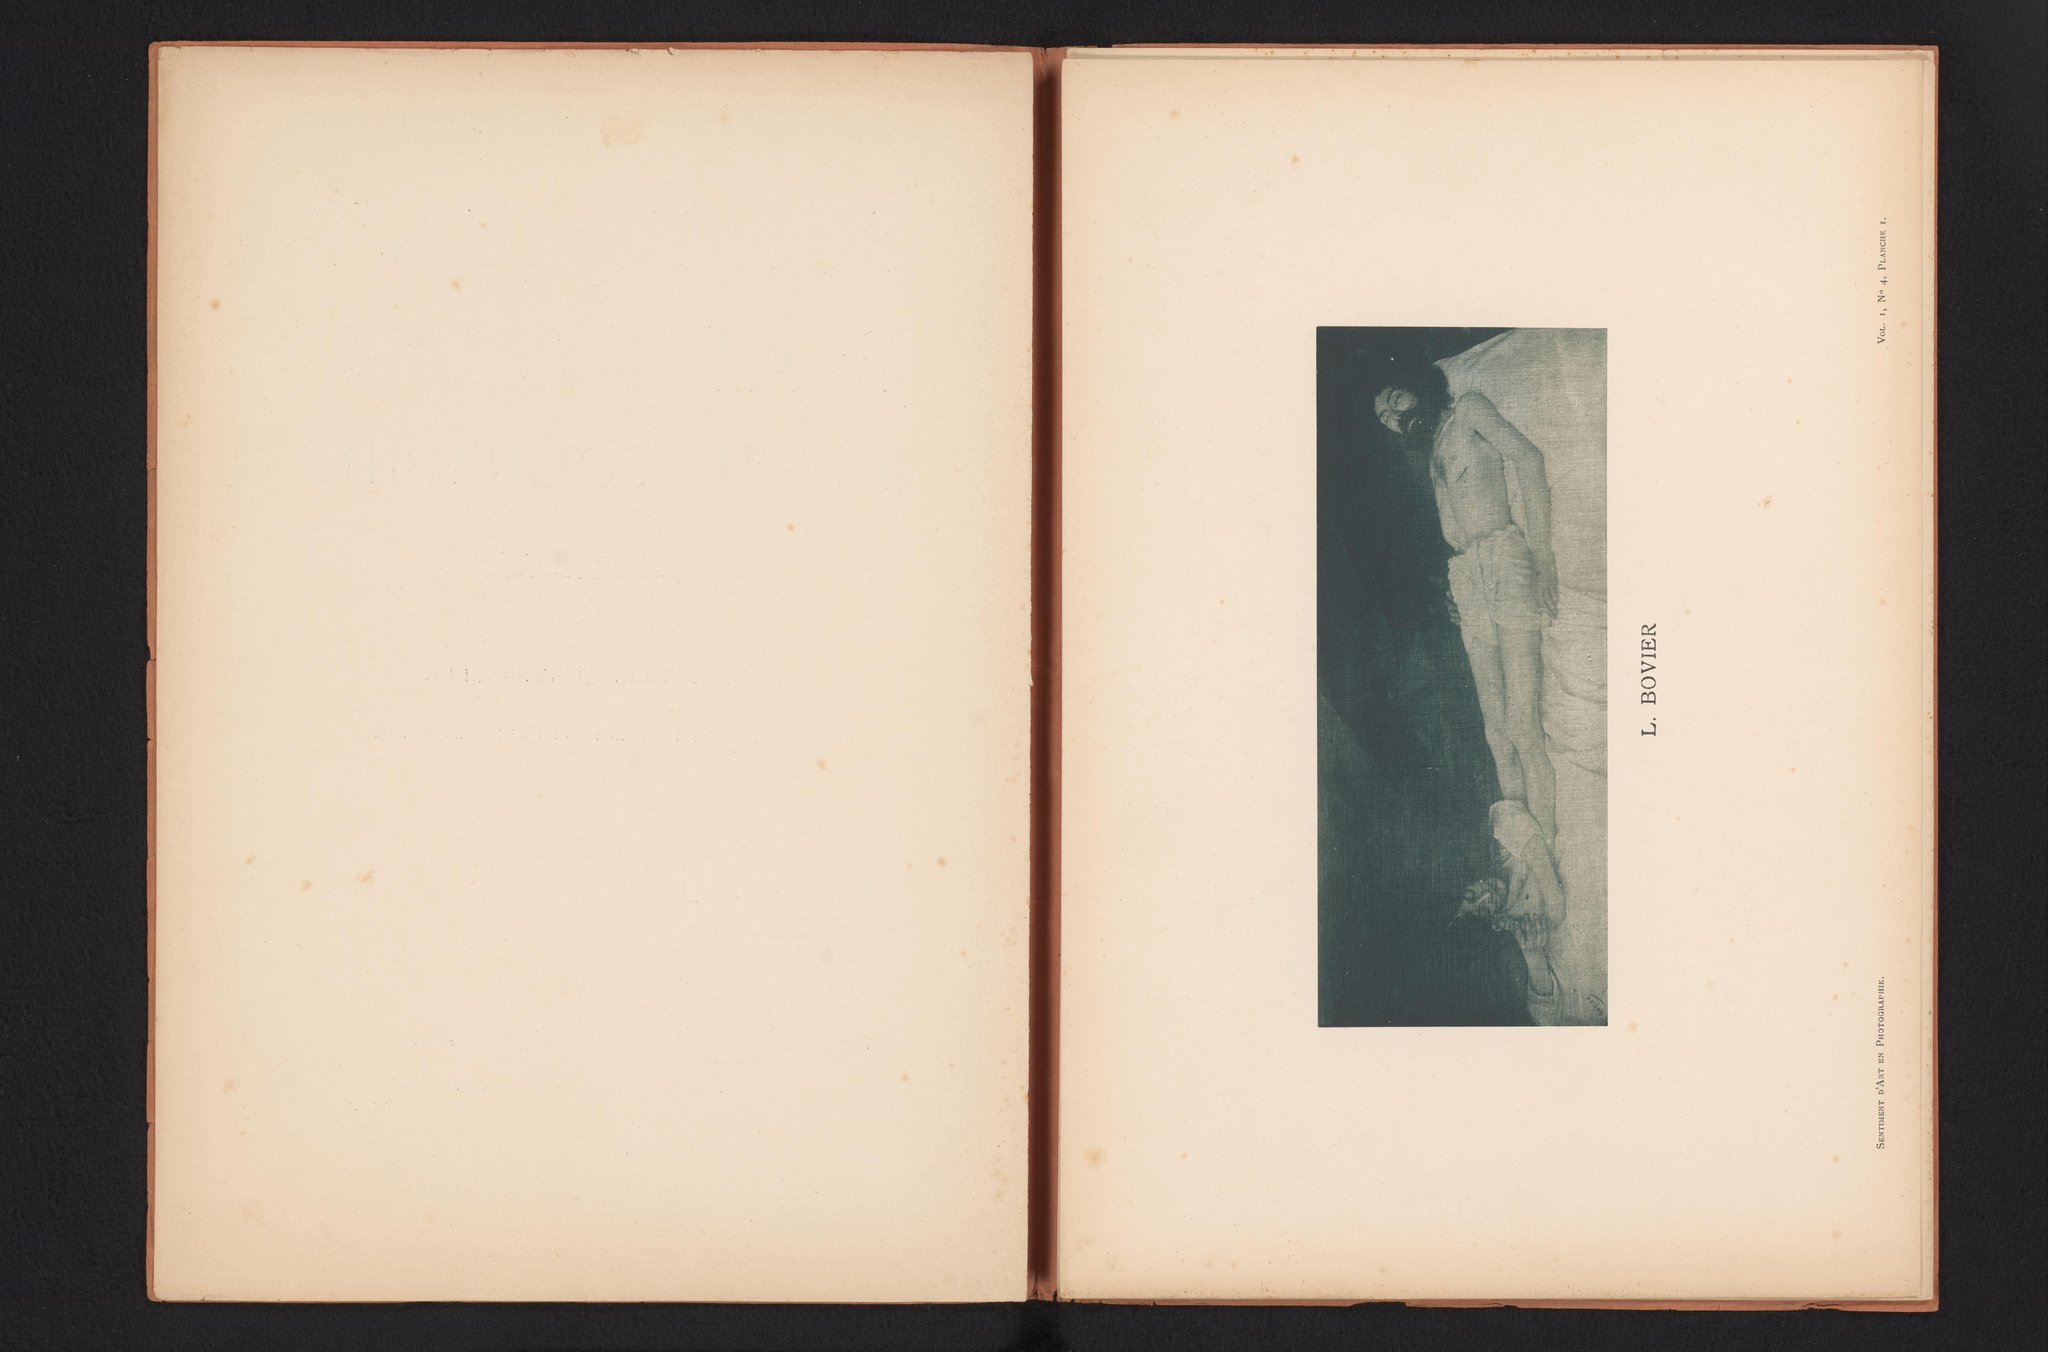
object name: photomechanical print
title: Vrouw, vermoedelijk Maria Magdalena, omhelst de voeten van het dode lichaam van Christus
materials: paper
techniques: photograph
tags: christ's feet are anointed by mary (magdalene)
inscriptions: number: ‘Vol. 1, No 4, Planche 1.’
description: Deze prent maakt deel uit van 8 omslagen met 22 tekstbladen en 89 prenten op losse bladen in en tussen de omslagen.